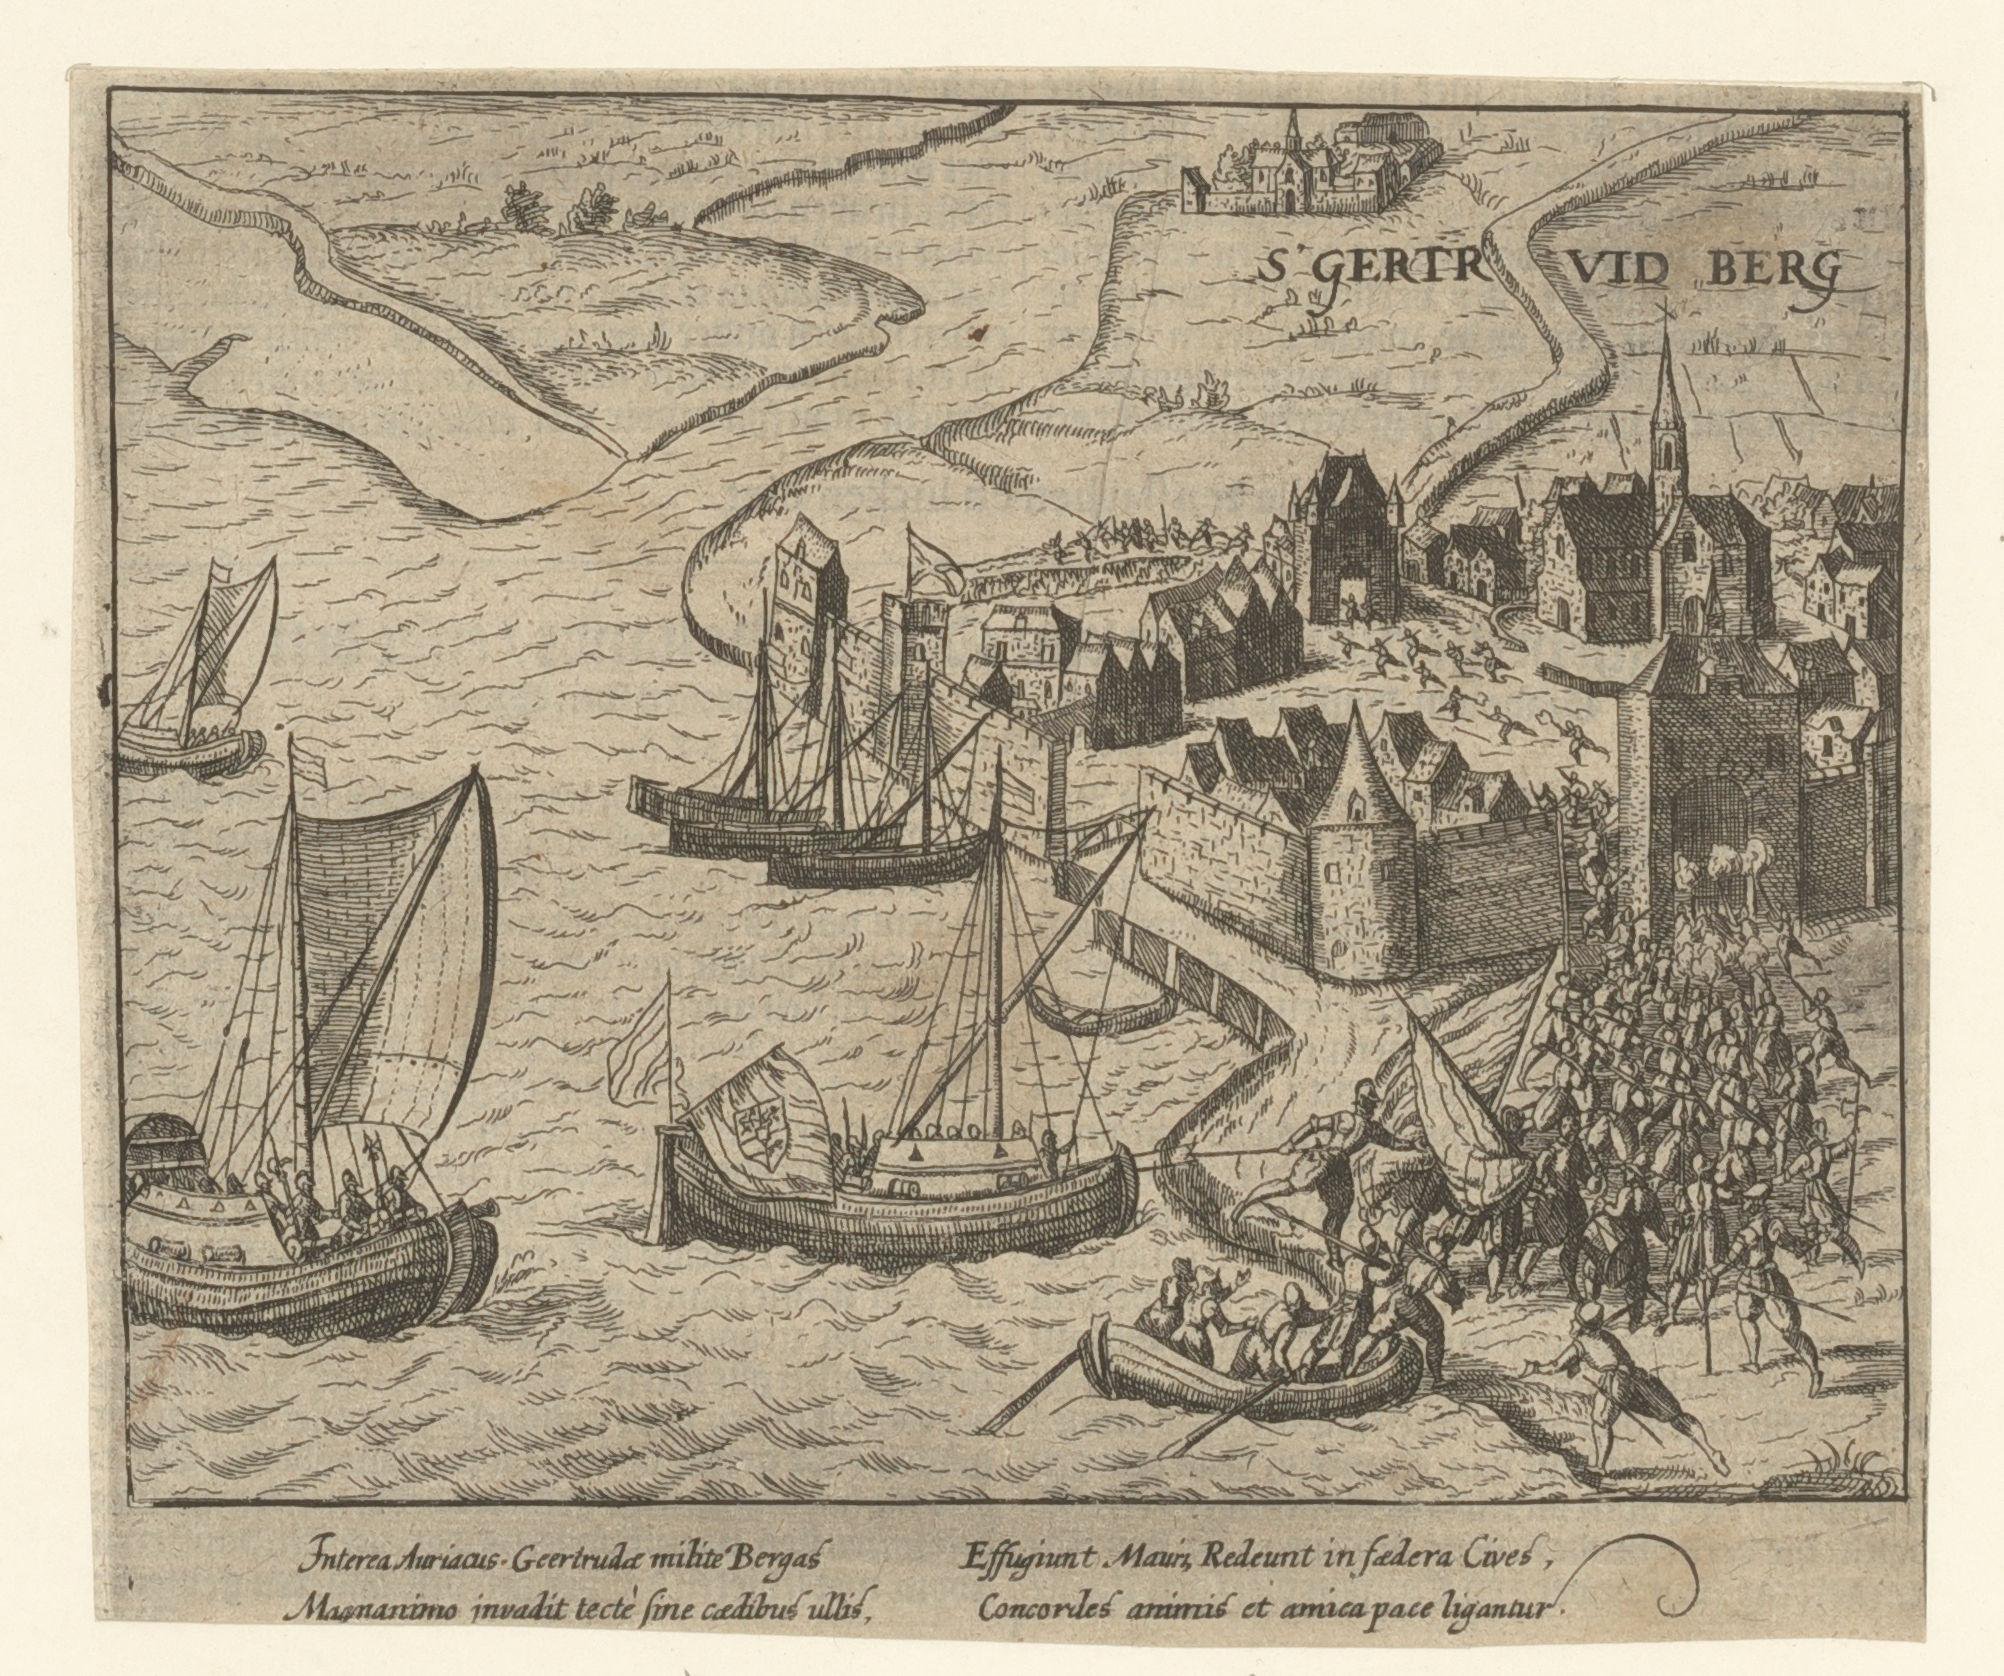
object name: history print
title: Inname van Geertruidenberg, 1593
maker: Anonymous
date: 1613-1615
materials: paper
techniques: etching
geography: northern netherlands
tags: the hague, maurice (prince of orange), capture of city (after the siege), geertruidenberg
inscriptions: collector's mark: Lugt 1641, collector's mark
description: Verovering van Geertruidenberg door het Staatse leger onder prins Maurits, 24 juni 1593. Schepen op het water voor de stad, rechts. Het Staatse leger trekt door de poort de stad binnen, aan de andere zijde vluchten de Spanjaarden de stad uit. Met onderschrift van 4 regels in het Latijn. Ongenummerd (volgens Muller nr. 212). Bedrukt op achterzijde met tekst in het Nederlands. Onderwerpsrubrieken binnen de Atlas Zeden en Gewoonten: Krijgswezen; prenten van Baudart. 80j. oorlog.